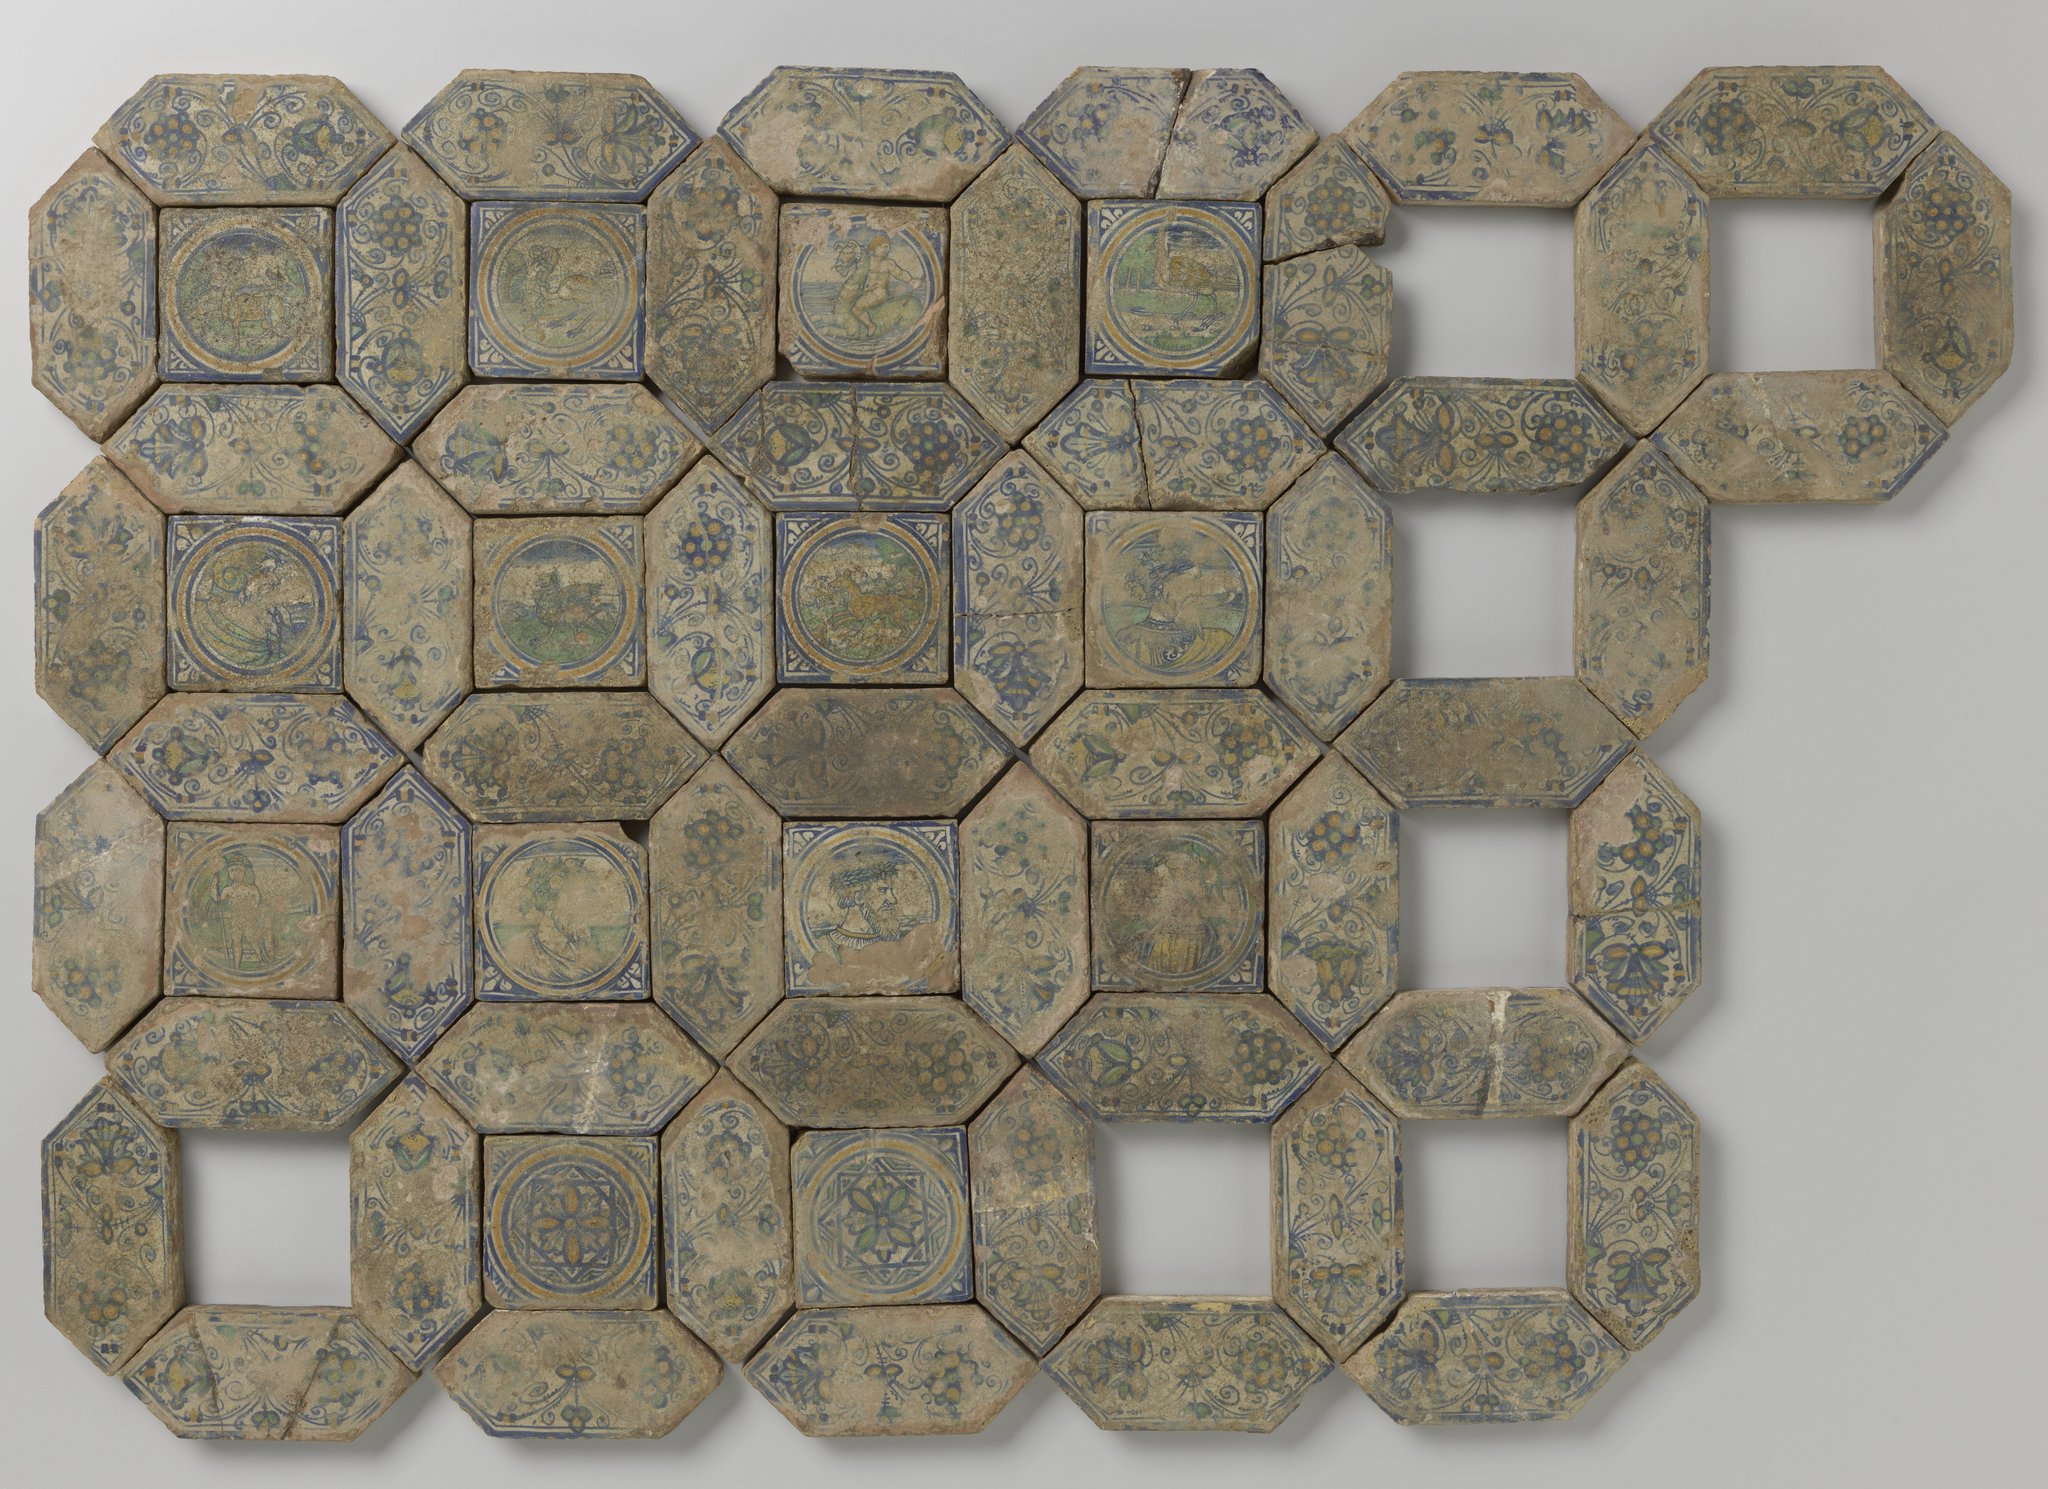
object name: floor tile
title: Dertien zeskantige vloertegels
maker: Anonymous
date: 1545-1570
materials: earthenware, glaze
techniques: maiolica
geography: antwerp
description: Dertien zeskantige vloertegels versierd met gestileerde bloemblad motieven. De randen zijn met brede biezen afgezet. In het midden van een lange zijde het wapen van de familie Montmorency.